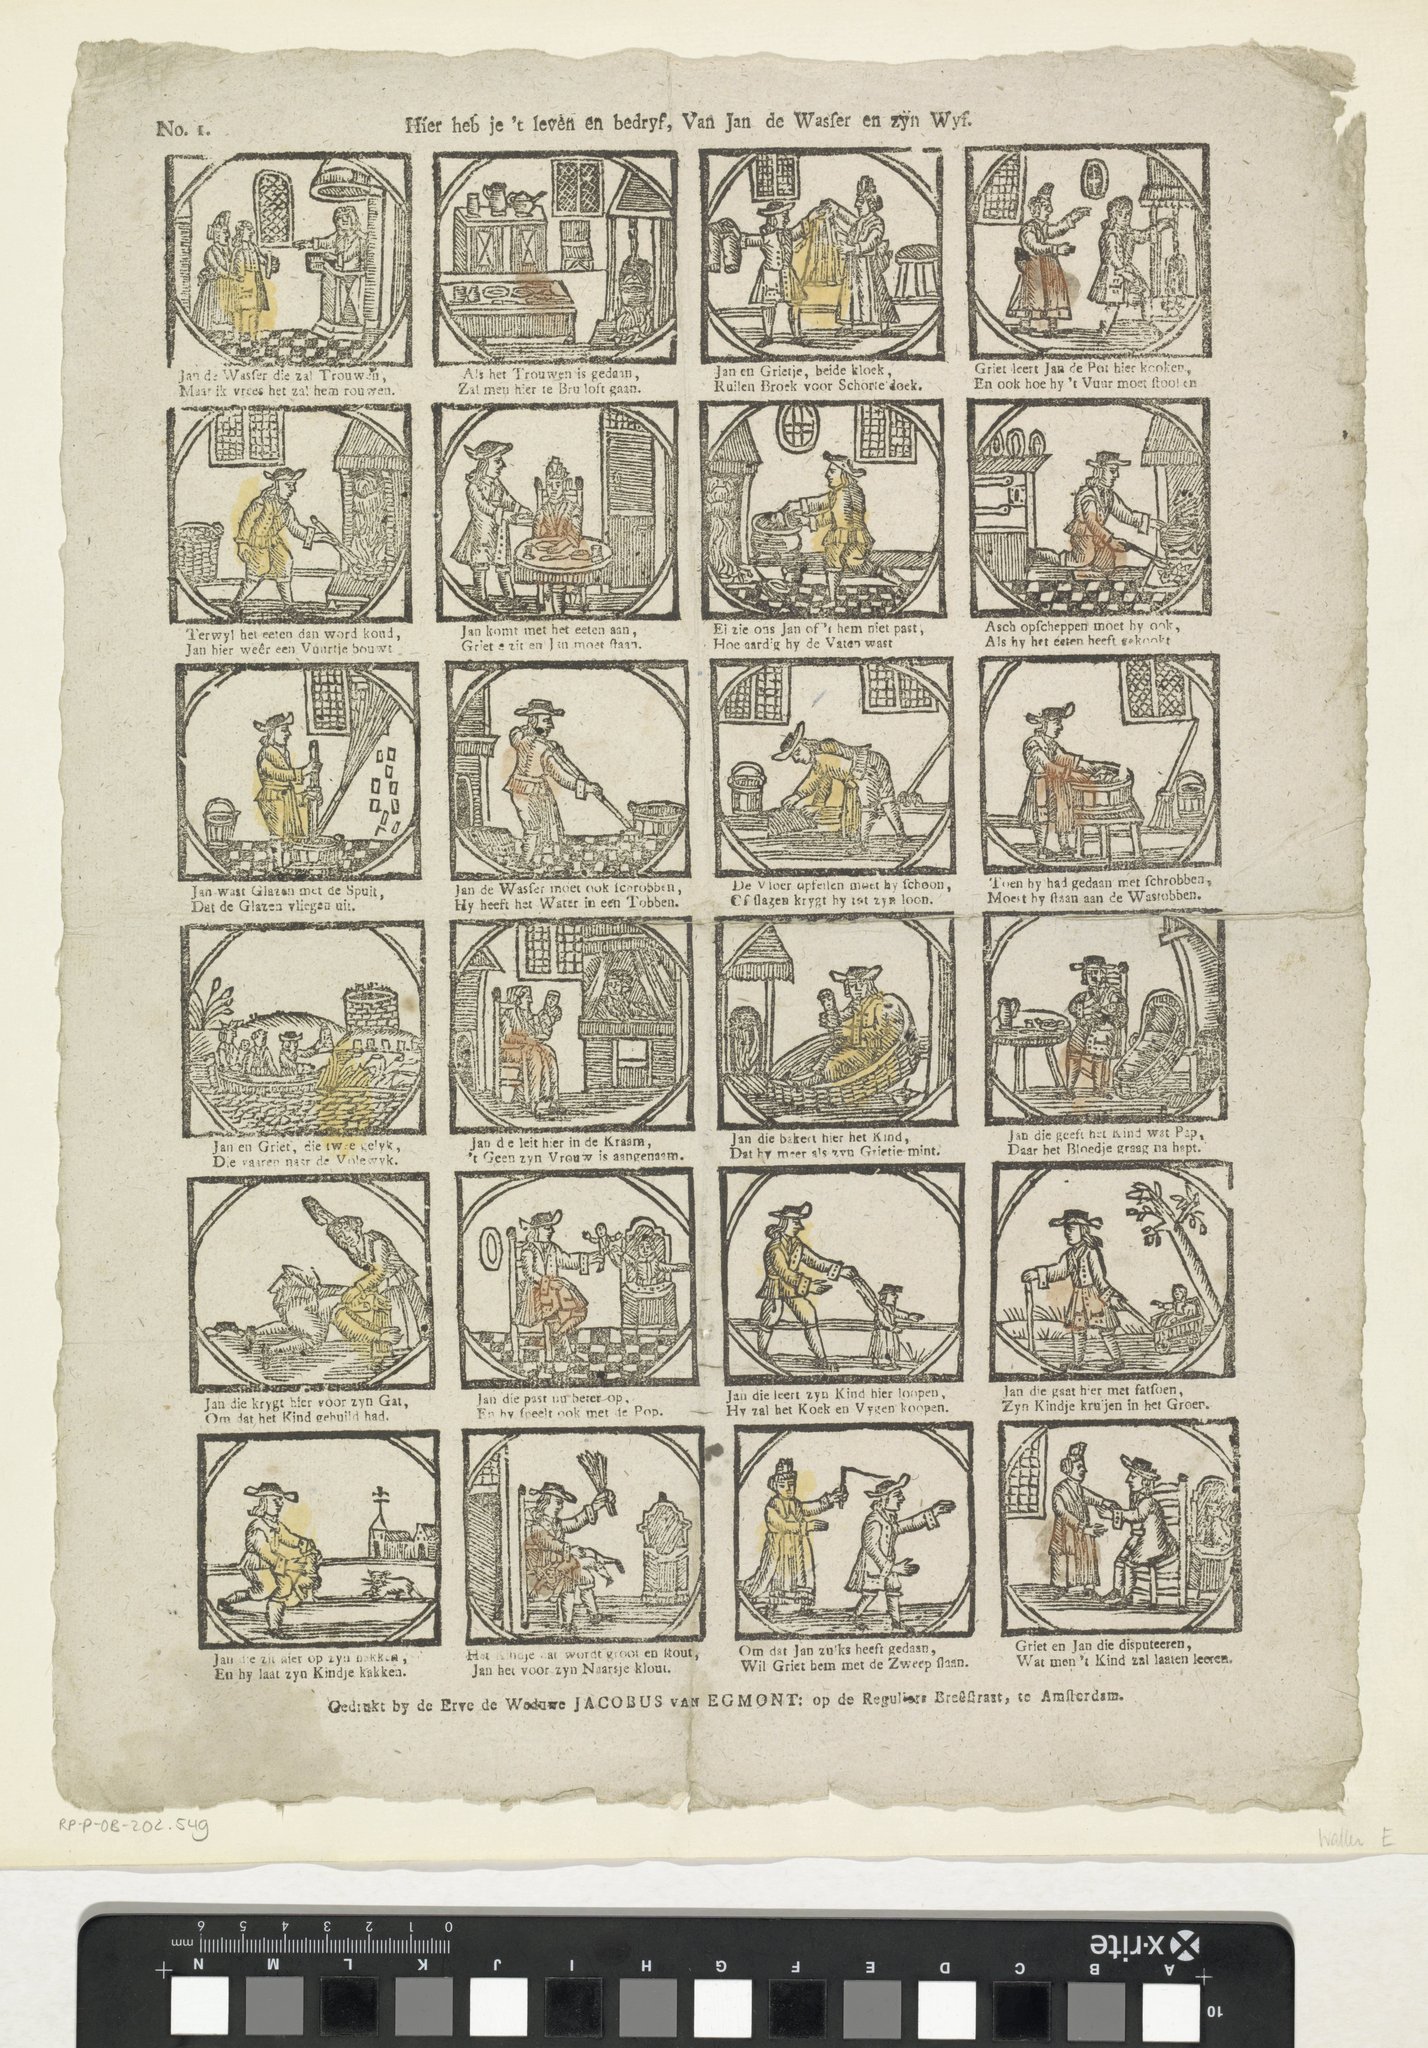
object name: print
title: Hier heb je 't leven en bedryf, van Jan de Wasser en zyn wyf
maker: Anonymous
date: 1761-1804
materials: paper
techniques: colour, letterpress printing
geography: netherlands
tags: hen-pecked husband, 'betty', 'molly' (man who engages in women's work)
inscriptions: collector's mark: Lugt 2760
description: Blad met 24 voorstellingen uit het leven van Jan de Wasser, een man die van zijn vrouw Griet, die de broek aan heeft, al het huishoudelijk werk moet doen. Onder elke afbeelding een tweeregelig vers. Genummerd linksboven: No. 1.